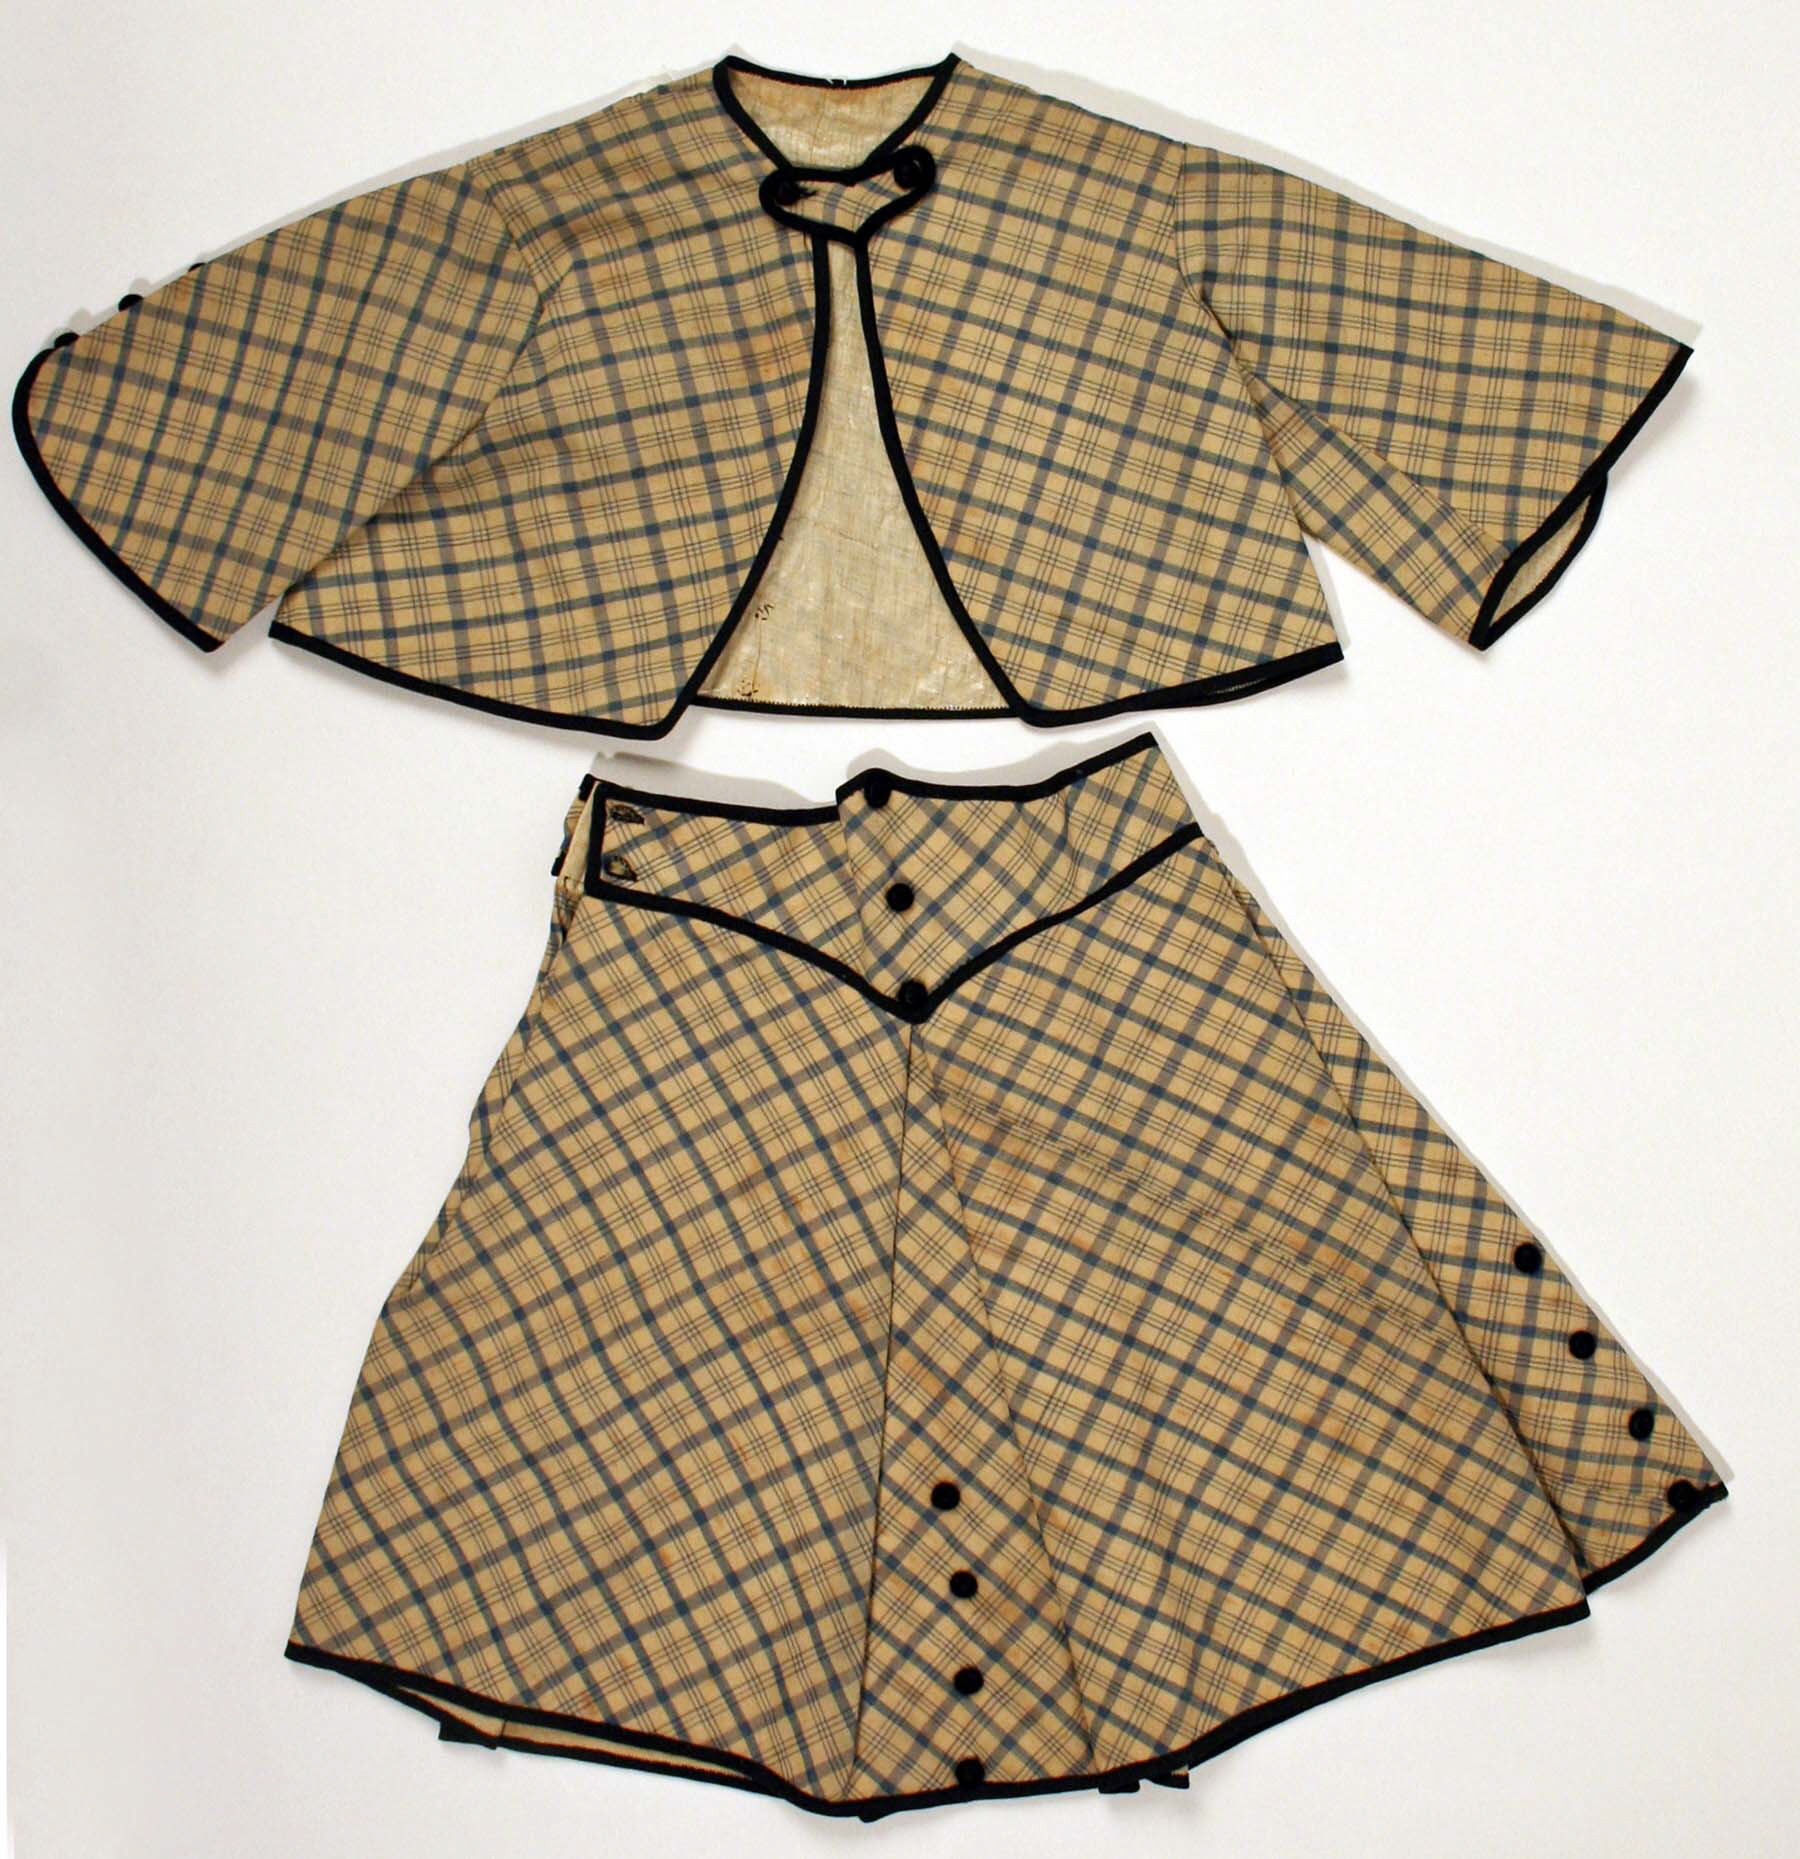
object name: dress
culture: american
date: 1850-1869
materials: wool